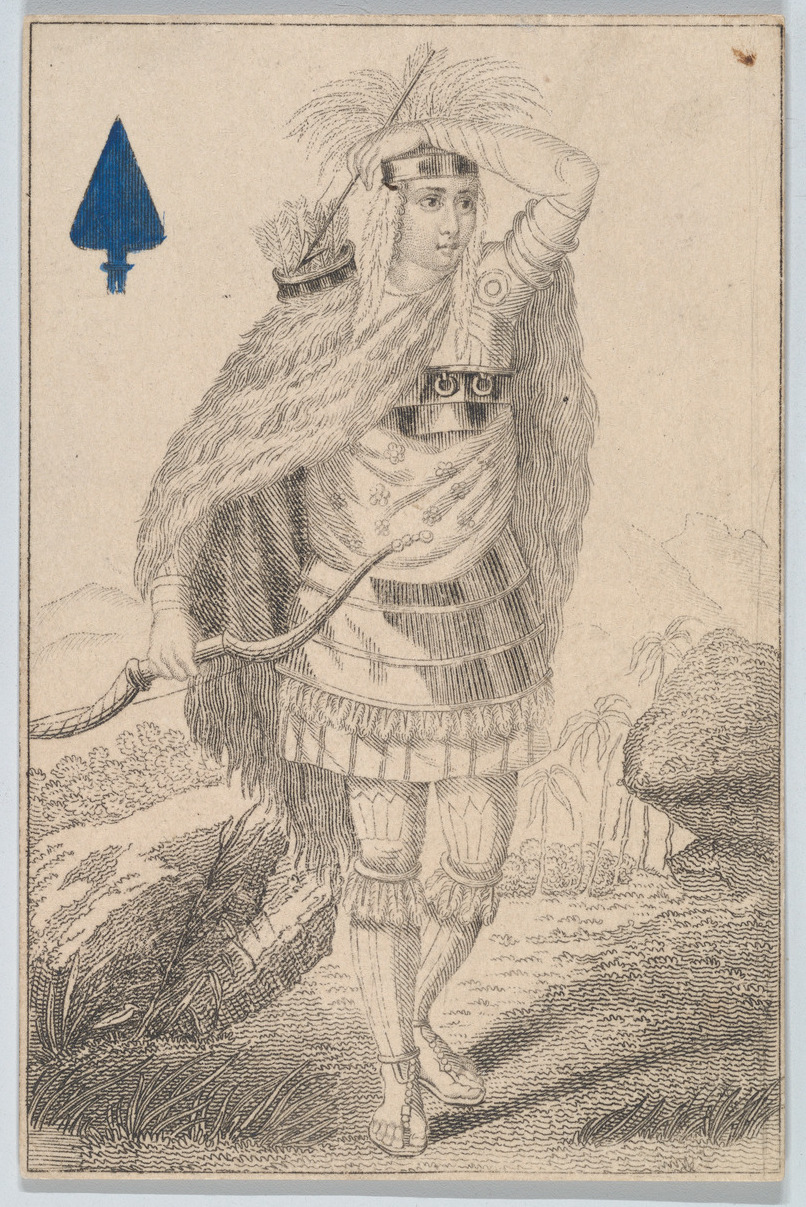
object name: print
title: Knave (Telasco from Mexico), from "Court Game of Geography"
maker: william and henry rock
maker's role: publisher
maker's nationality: british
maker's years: 1821-1884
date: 1838-1855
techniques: engraving, etching, hand coloring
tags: bow and arrow,men,playing cards